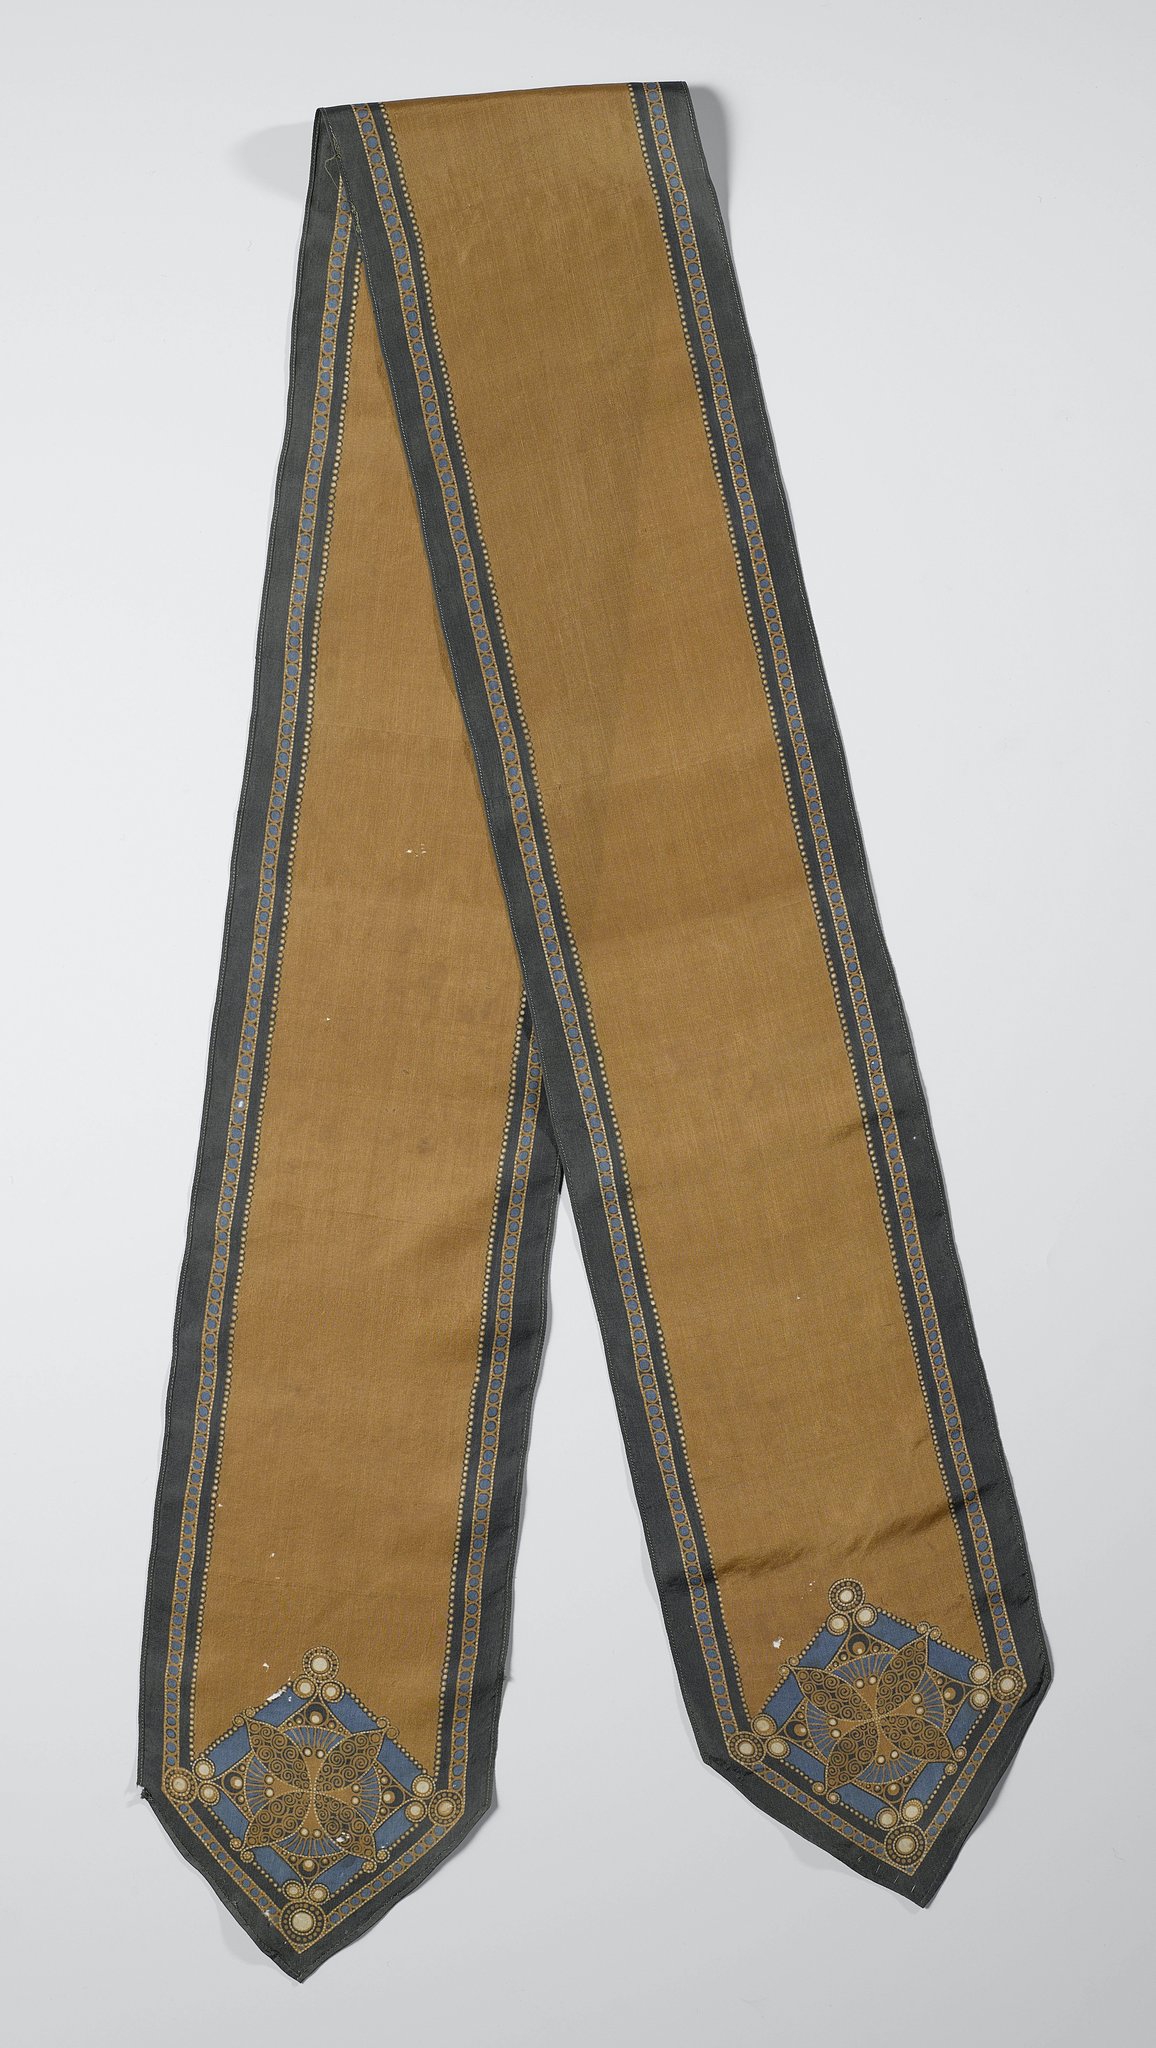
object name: neckcloth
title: Langwerpige gebatikte sjaal in bruin, groen, zwart, blauw en wit, met onversierd bruin middeldeel binnen een groene rand, stermotief in de twee puntige uiteinden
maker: chris lebeau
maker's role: draughtsman, print maker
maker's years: 1878-1945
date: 1900-1920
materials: silk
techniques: weave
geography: netherlands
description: Langwerpige gebatikte sjaal met onversierd goud-geel middeldeel binnen een groene rand, waarlangs een smalle rij aaneengesloten bruin omlijnde blauwe cirkels en een witte stippelrand. Een stermotief gevuld met spiraalvormige cirkels, tegen blauw fond in de twee puntige uiteinden in de twee puntige uiteinden.